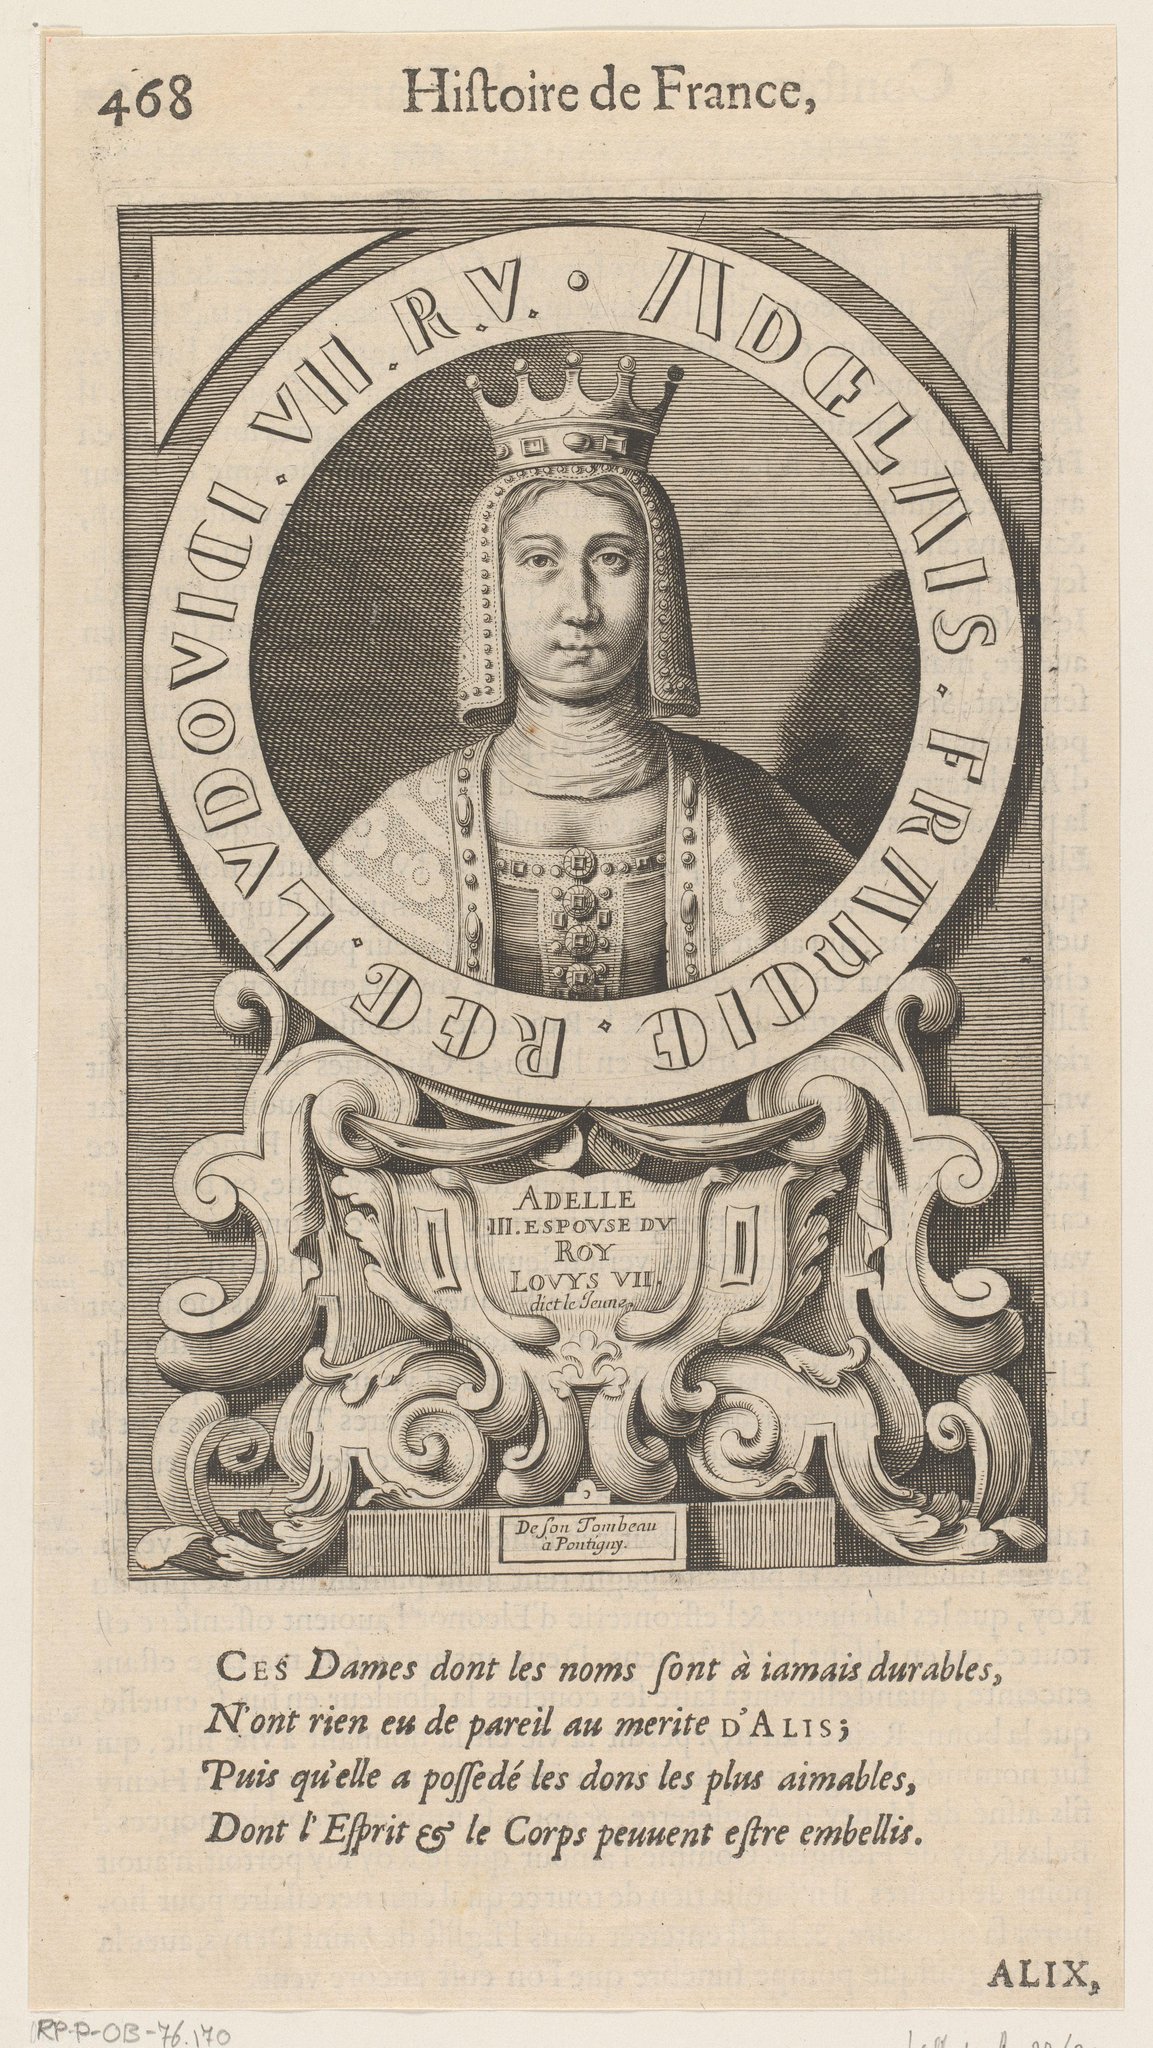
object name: book illustration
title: Adelle III espouse du roy Louys VII dict le Jeune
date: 1643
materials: paper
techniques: engraving, letterpress printing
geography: paris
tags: historical persons, queen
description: Prent uit: Eudes de Mézeray, François. Histoire de France, depuis Faramond jusqu’au regne de Louis le Juste (...). 3 dln. Parijs: Mathieu Guillemot, 1643, dl. 2. Prent waarschijnlijk voor het eerst verschenen in: Bie, Jacques de. Les vrais portraits des rois de France (...). Parijs: Jacques de Bie en Pierre Rocolet, 1634. Prent ook gebruikt in latere publicaties.